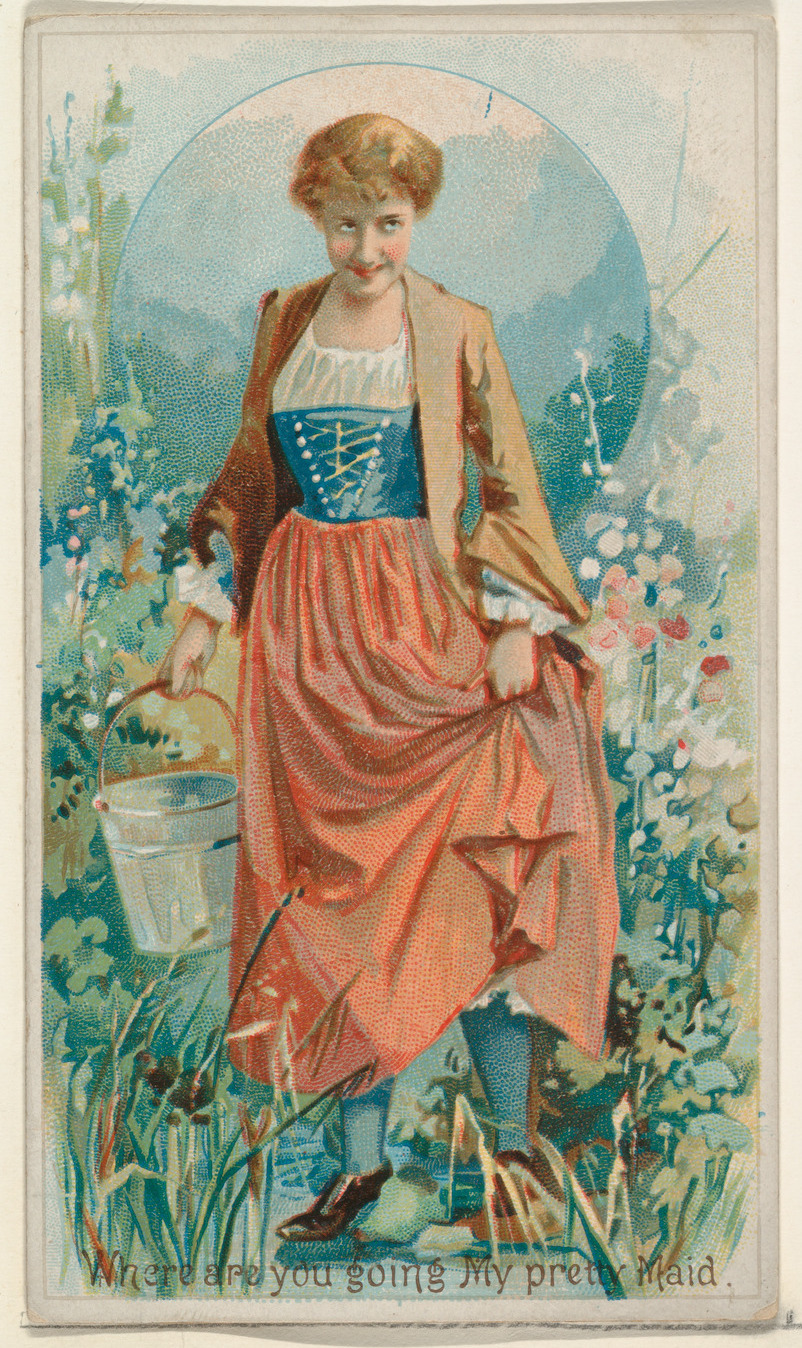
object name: print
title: Where Are You Going My Pretty Maid, from the Illustrated Songs series (N116) issued by W. Duke, Sons & Co. to promote Honest Long Cut Tobacco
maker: w. duke, sons & co.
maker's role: publisher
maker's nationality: american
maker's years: 1870-1920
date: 1893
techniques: color lithograph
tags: women